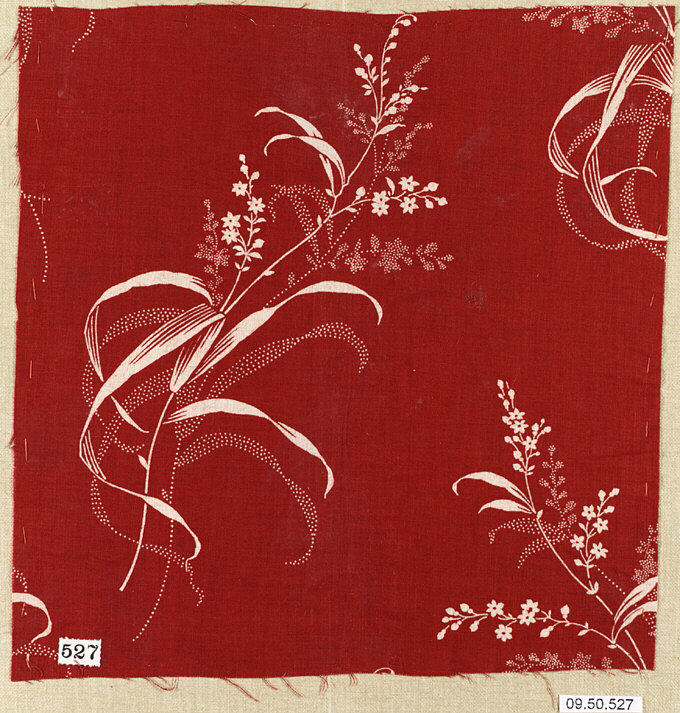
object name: piece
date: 1801-1900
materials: cotton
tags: flowers,leaves